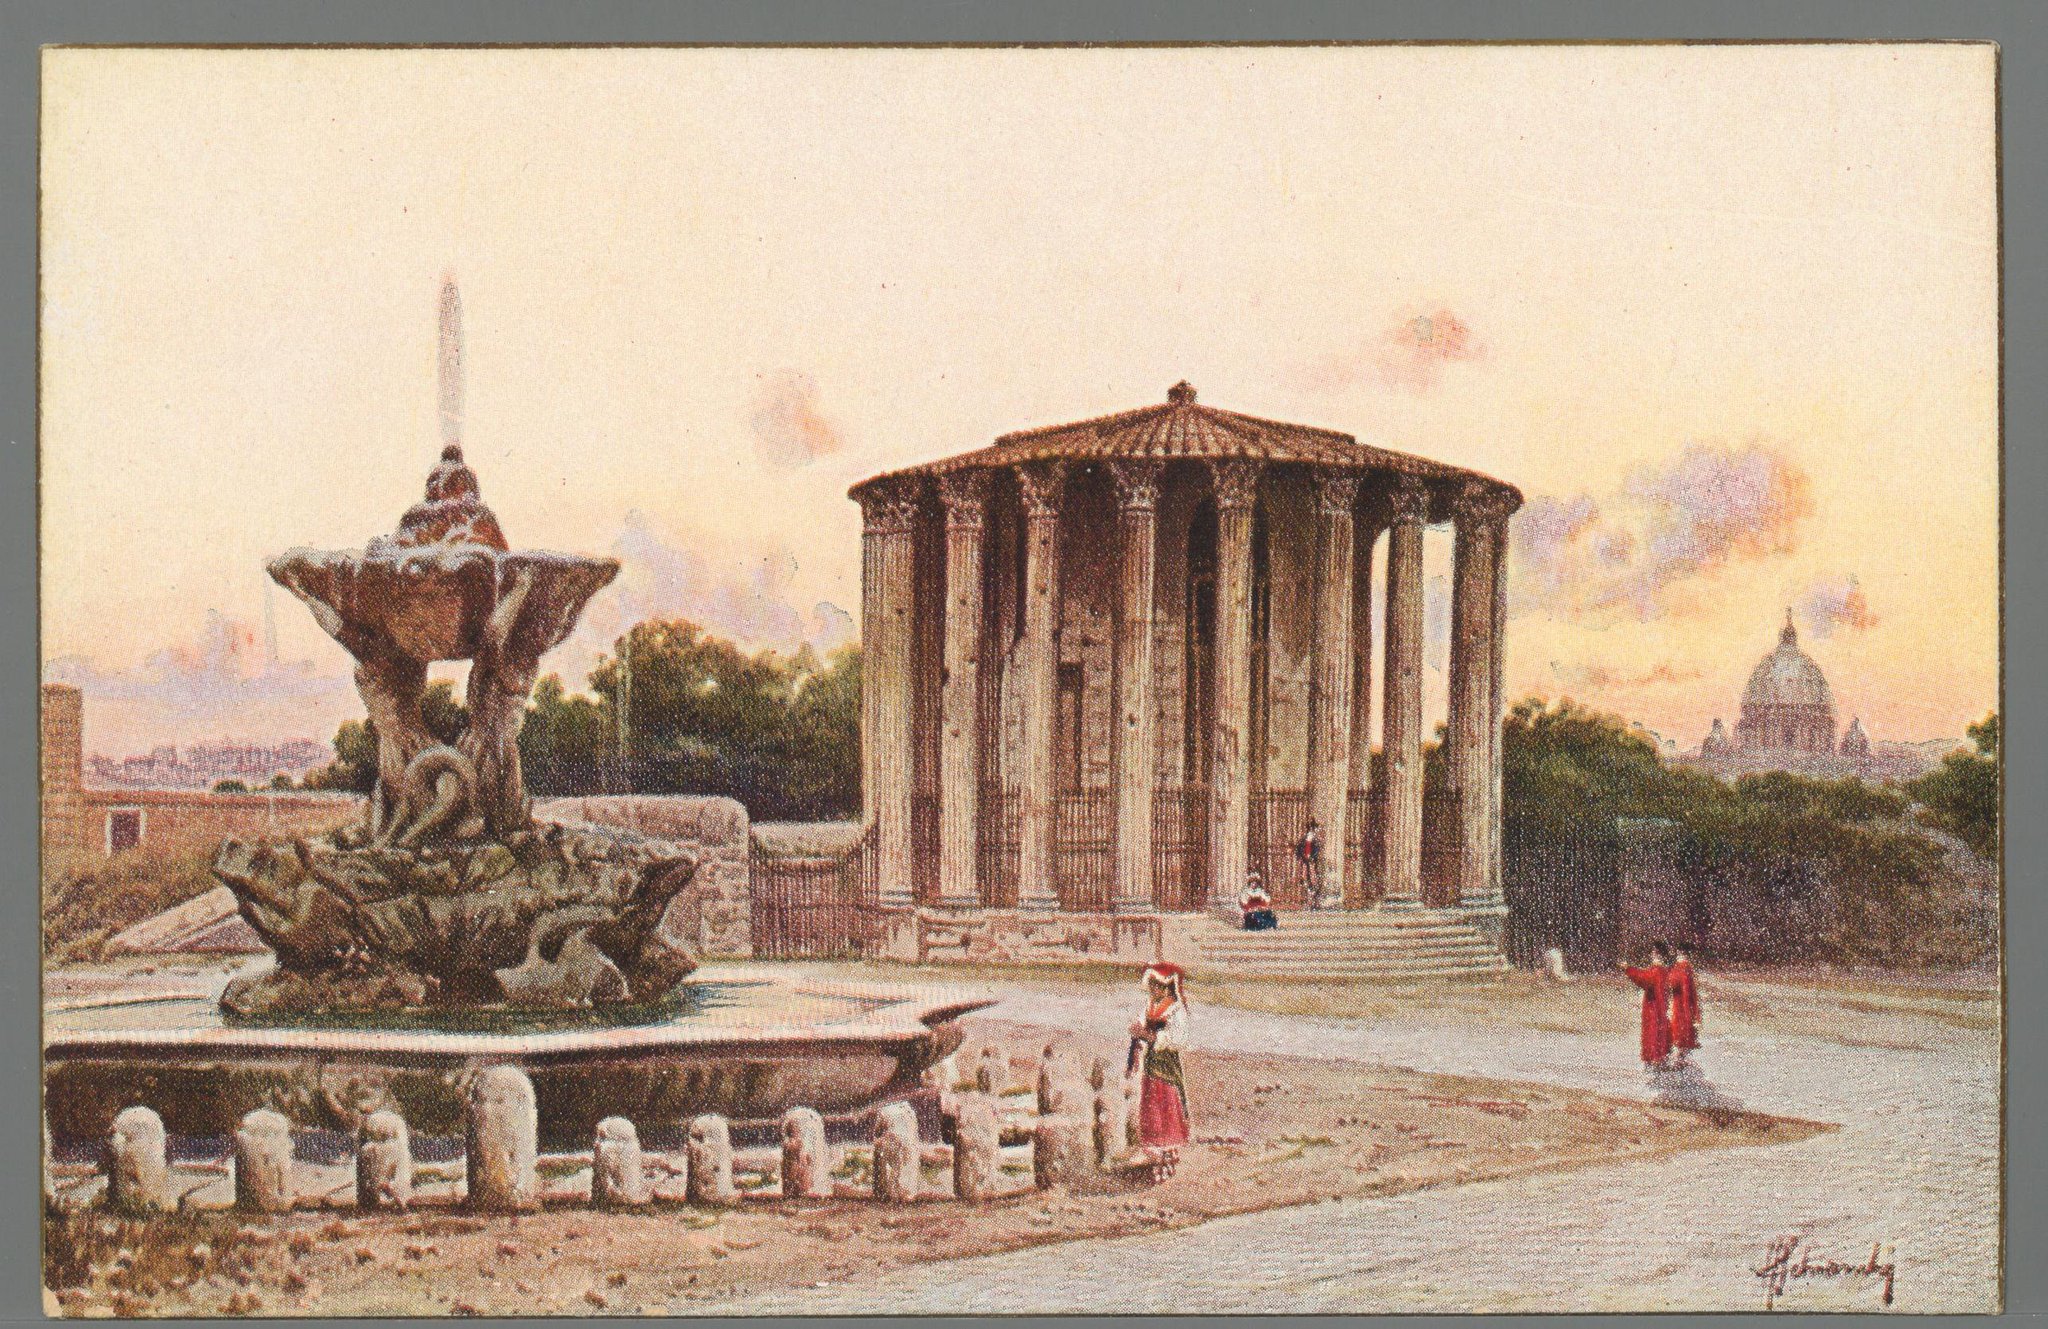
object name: reproduction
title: Roma. Tempio di Vesta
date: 1906-1930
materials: cardboard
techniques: four-color autotype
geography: florence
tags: temple, shrine ~ roman religion, city-view, and landscape with man-made constructions (+ city(-scape) with figures, staffage), ornamental fountain (+ city(-scape) with figures, staffage)